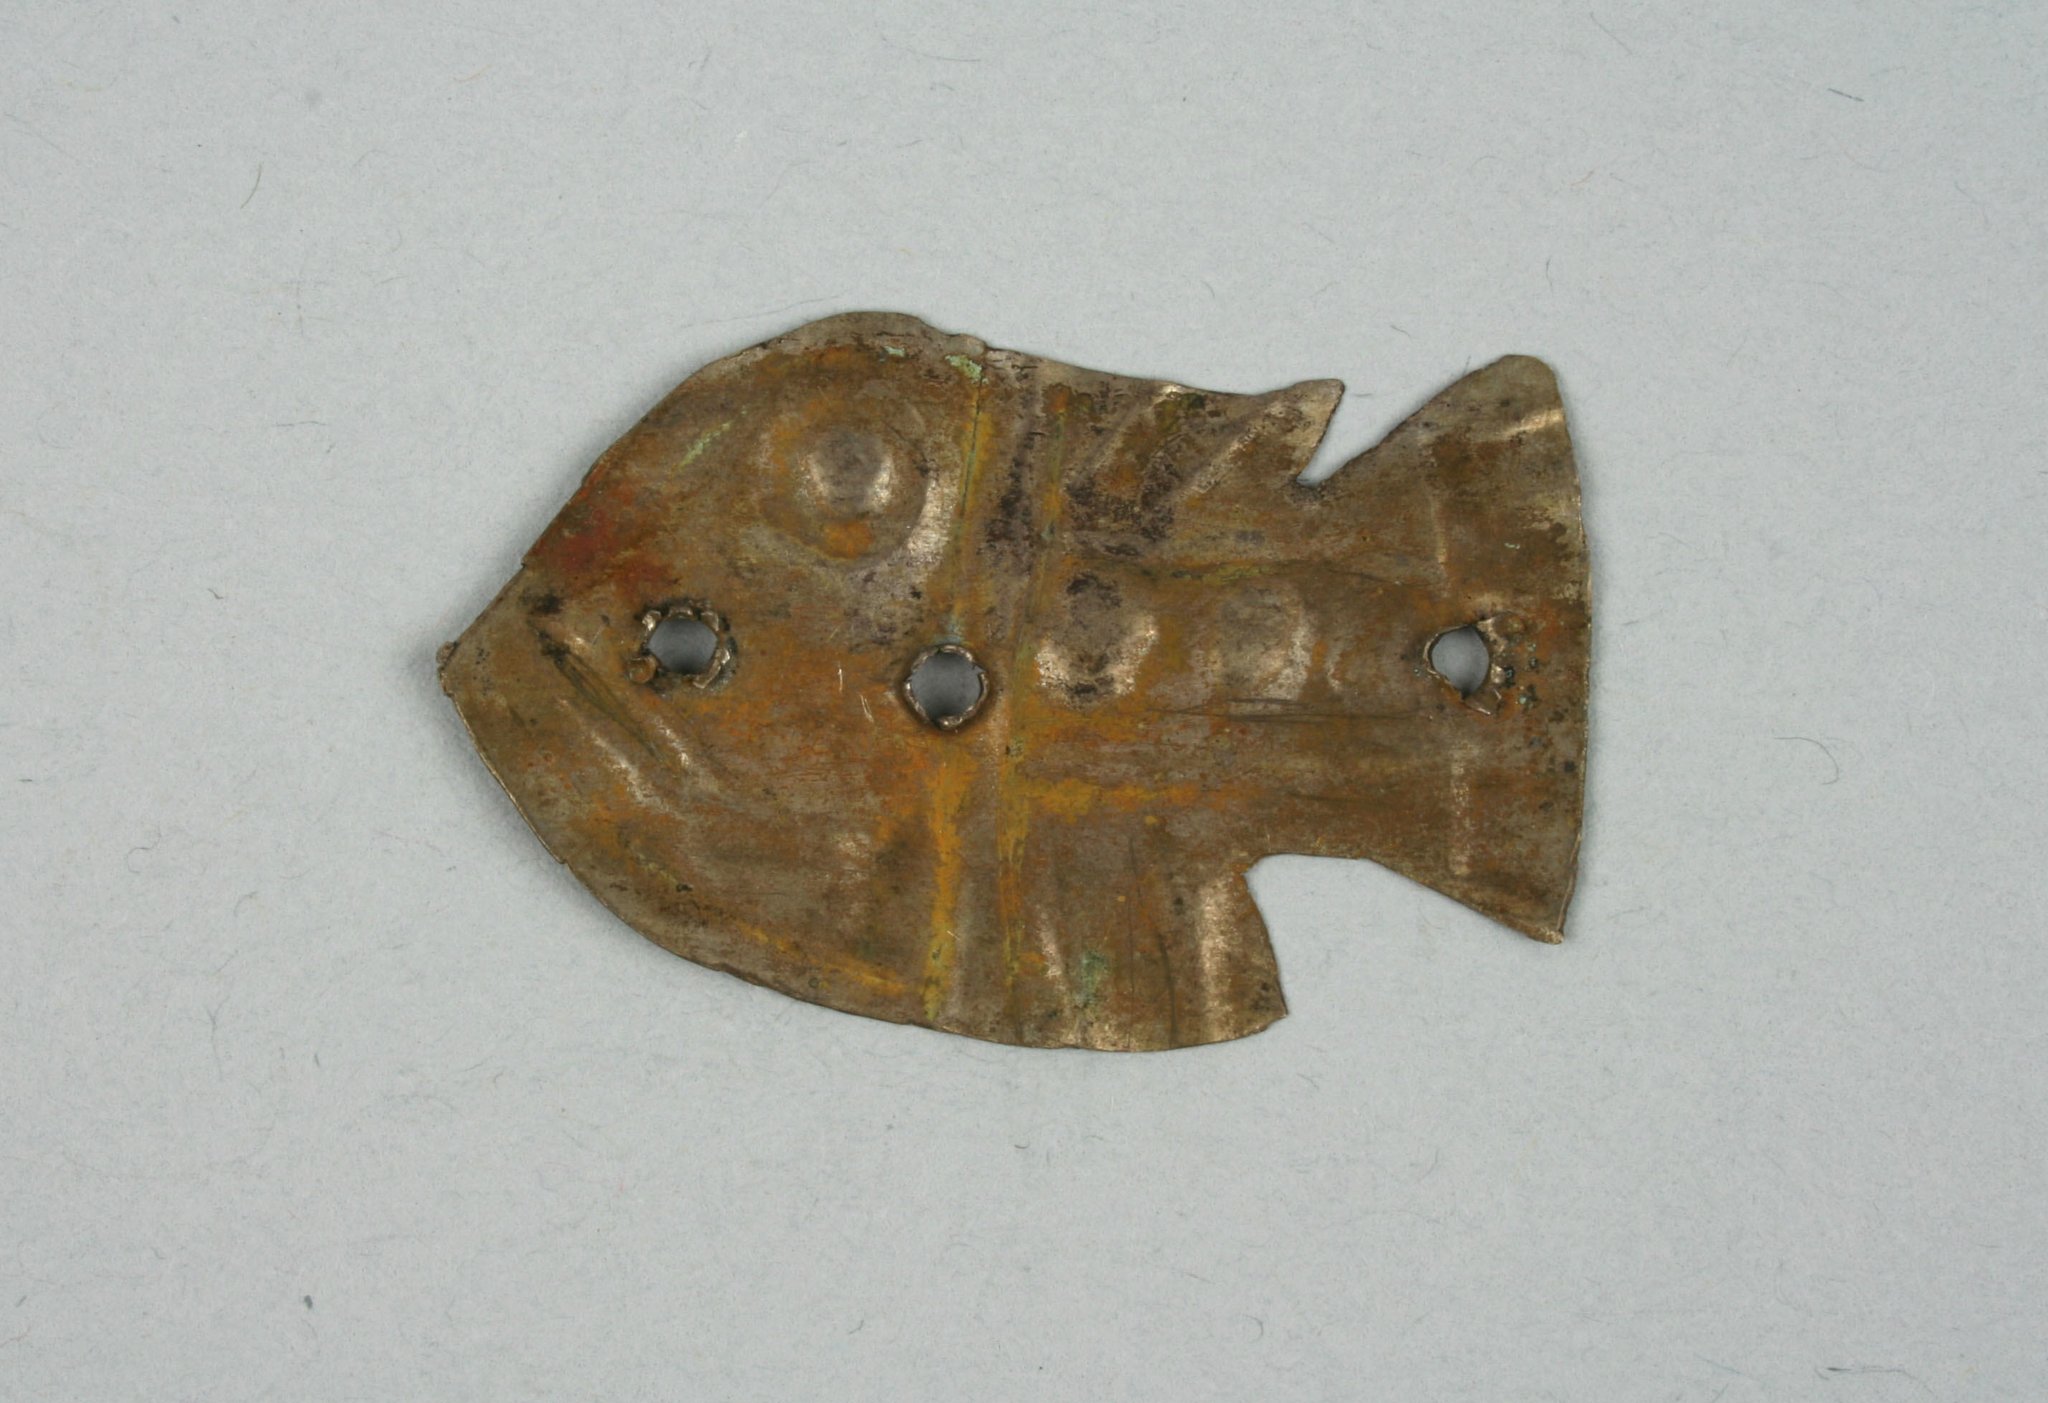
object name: ornament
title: Fish Ornament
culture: peruvian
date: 1001-1200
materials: silver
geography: peru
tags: fish